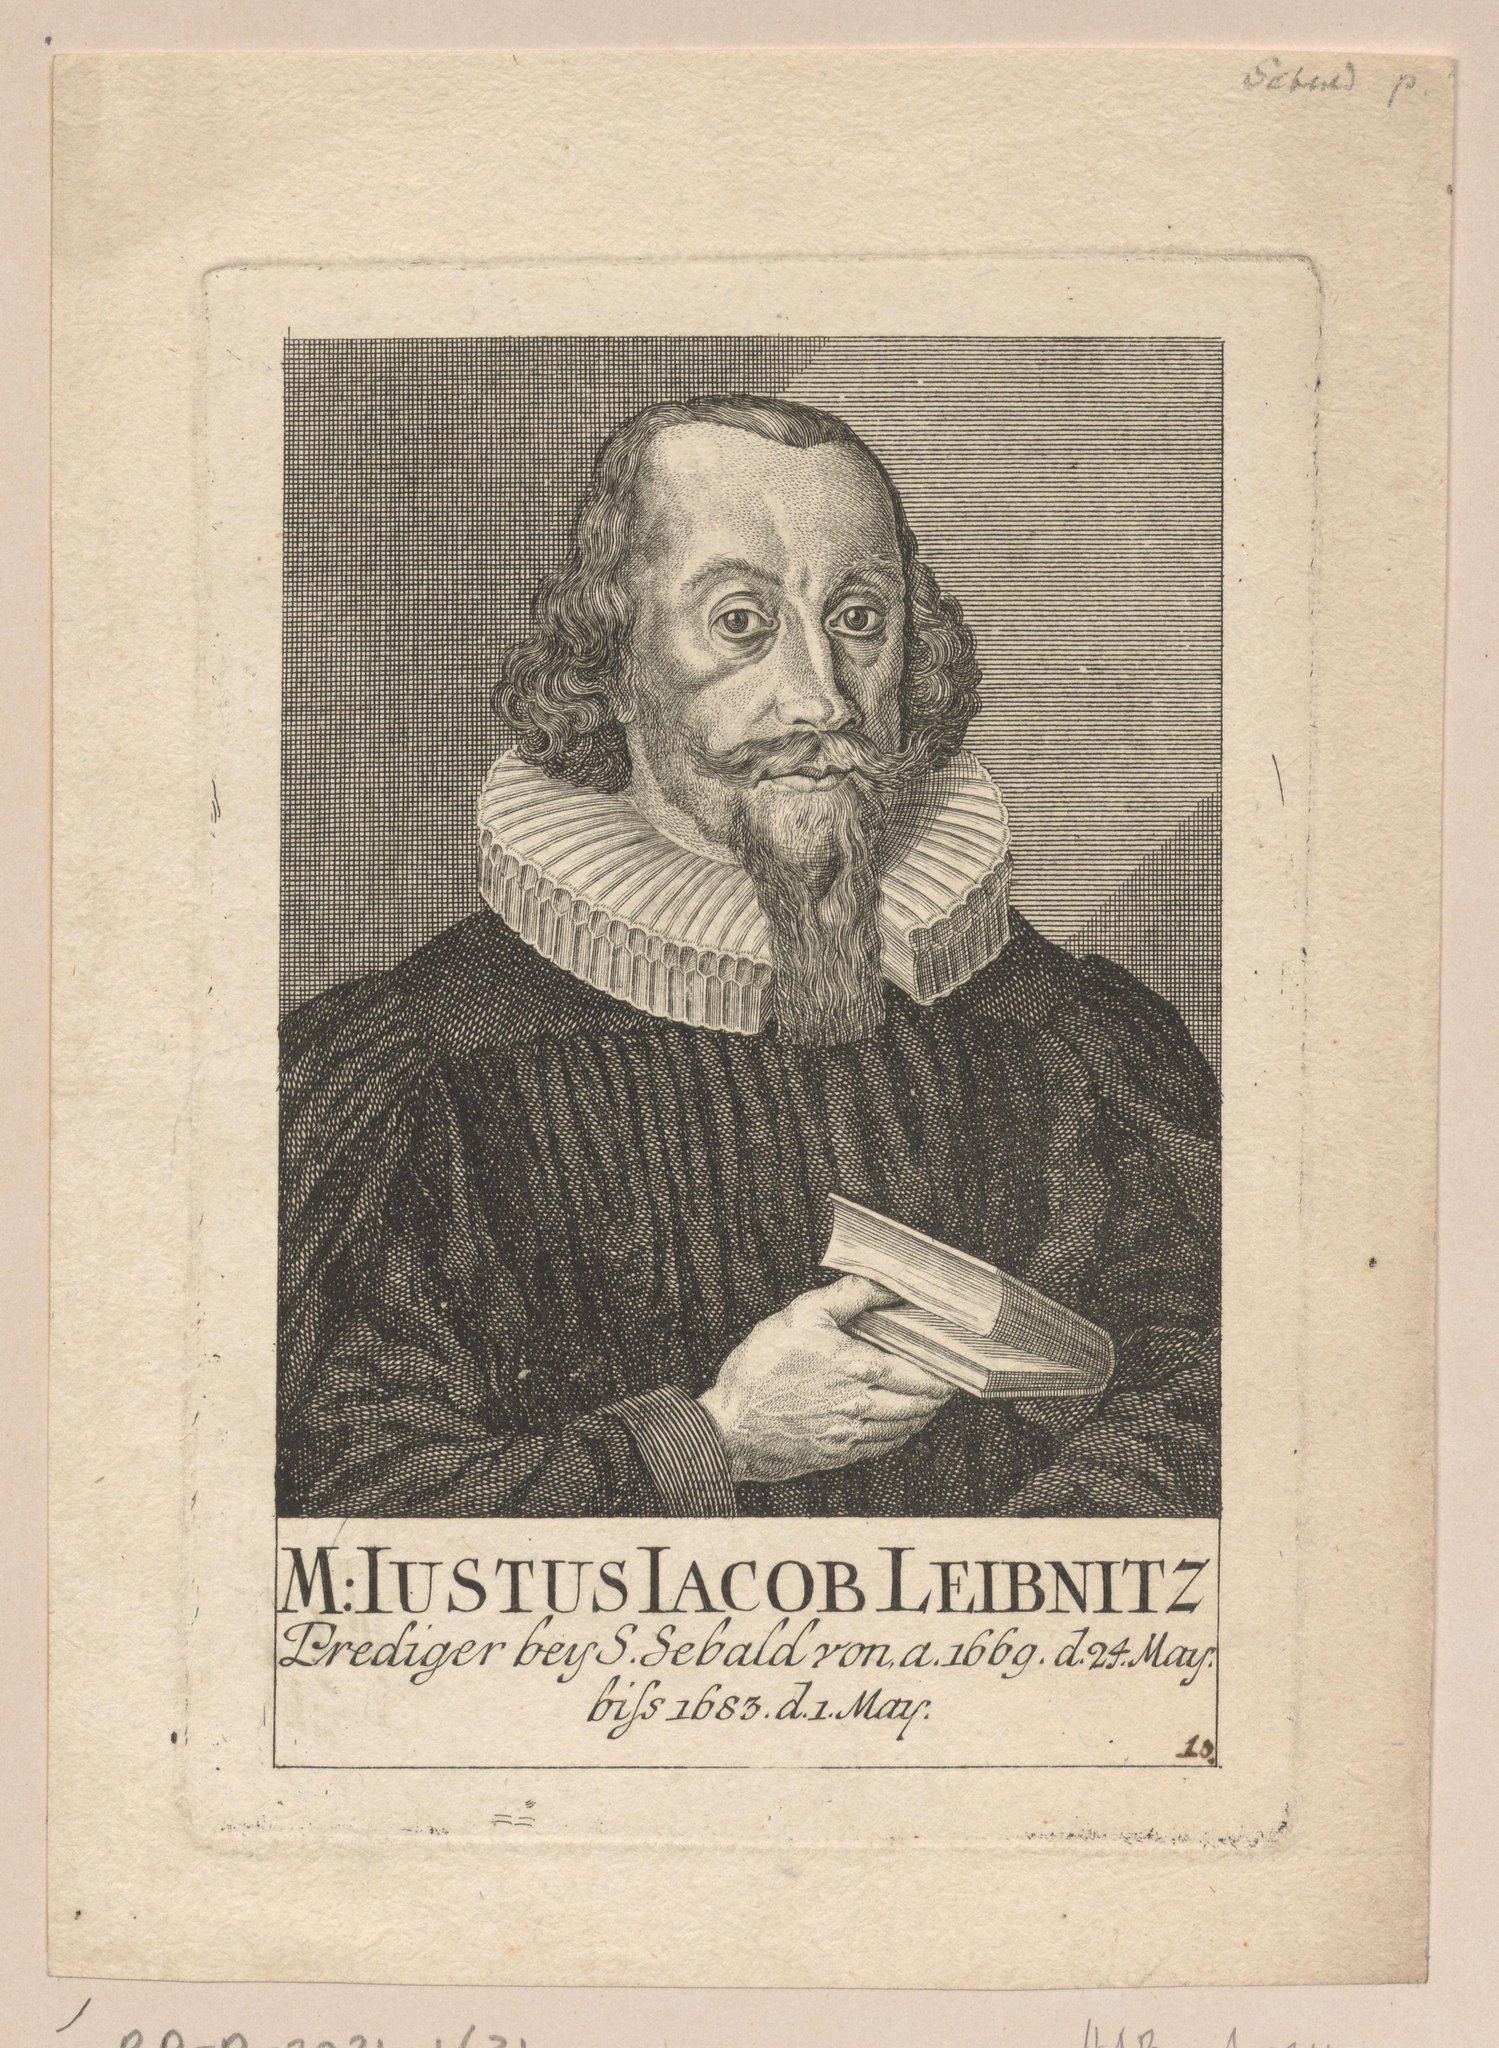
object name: print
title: Portret van Justus Jacob Leibnitz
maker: Anonymous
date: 1756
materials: paper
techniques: engraving, etching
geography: germany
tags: historical persons, book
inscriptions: number: ‘10’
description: Prent waarschijnlijk uit: Würfel, Andreas. Diptycha ecclesiae Sebaldianae (...). Neurenberg: Christoph Melchior Roth, 1756.